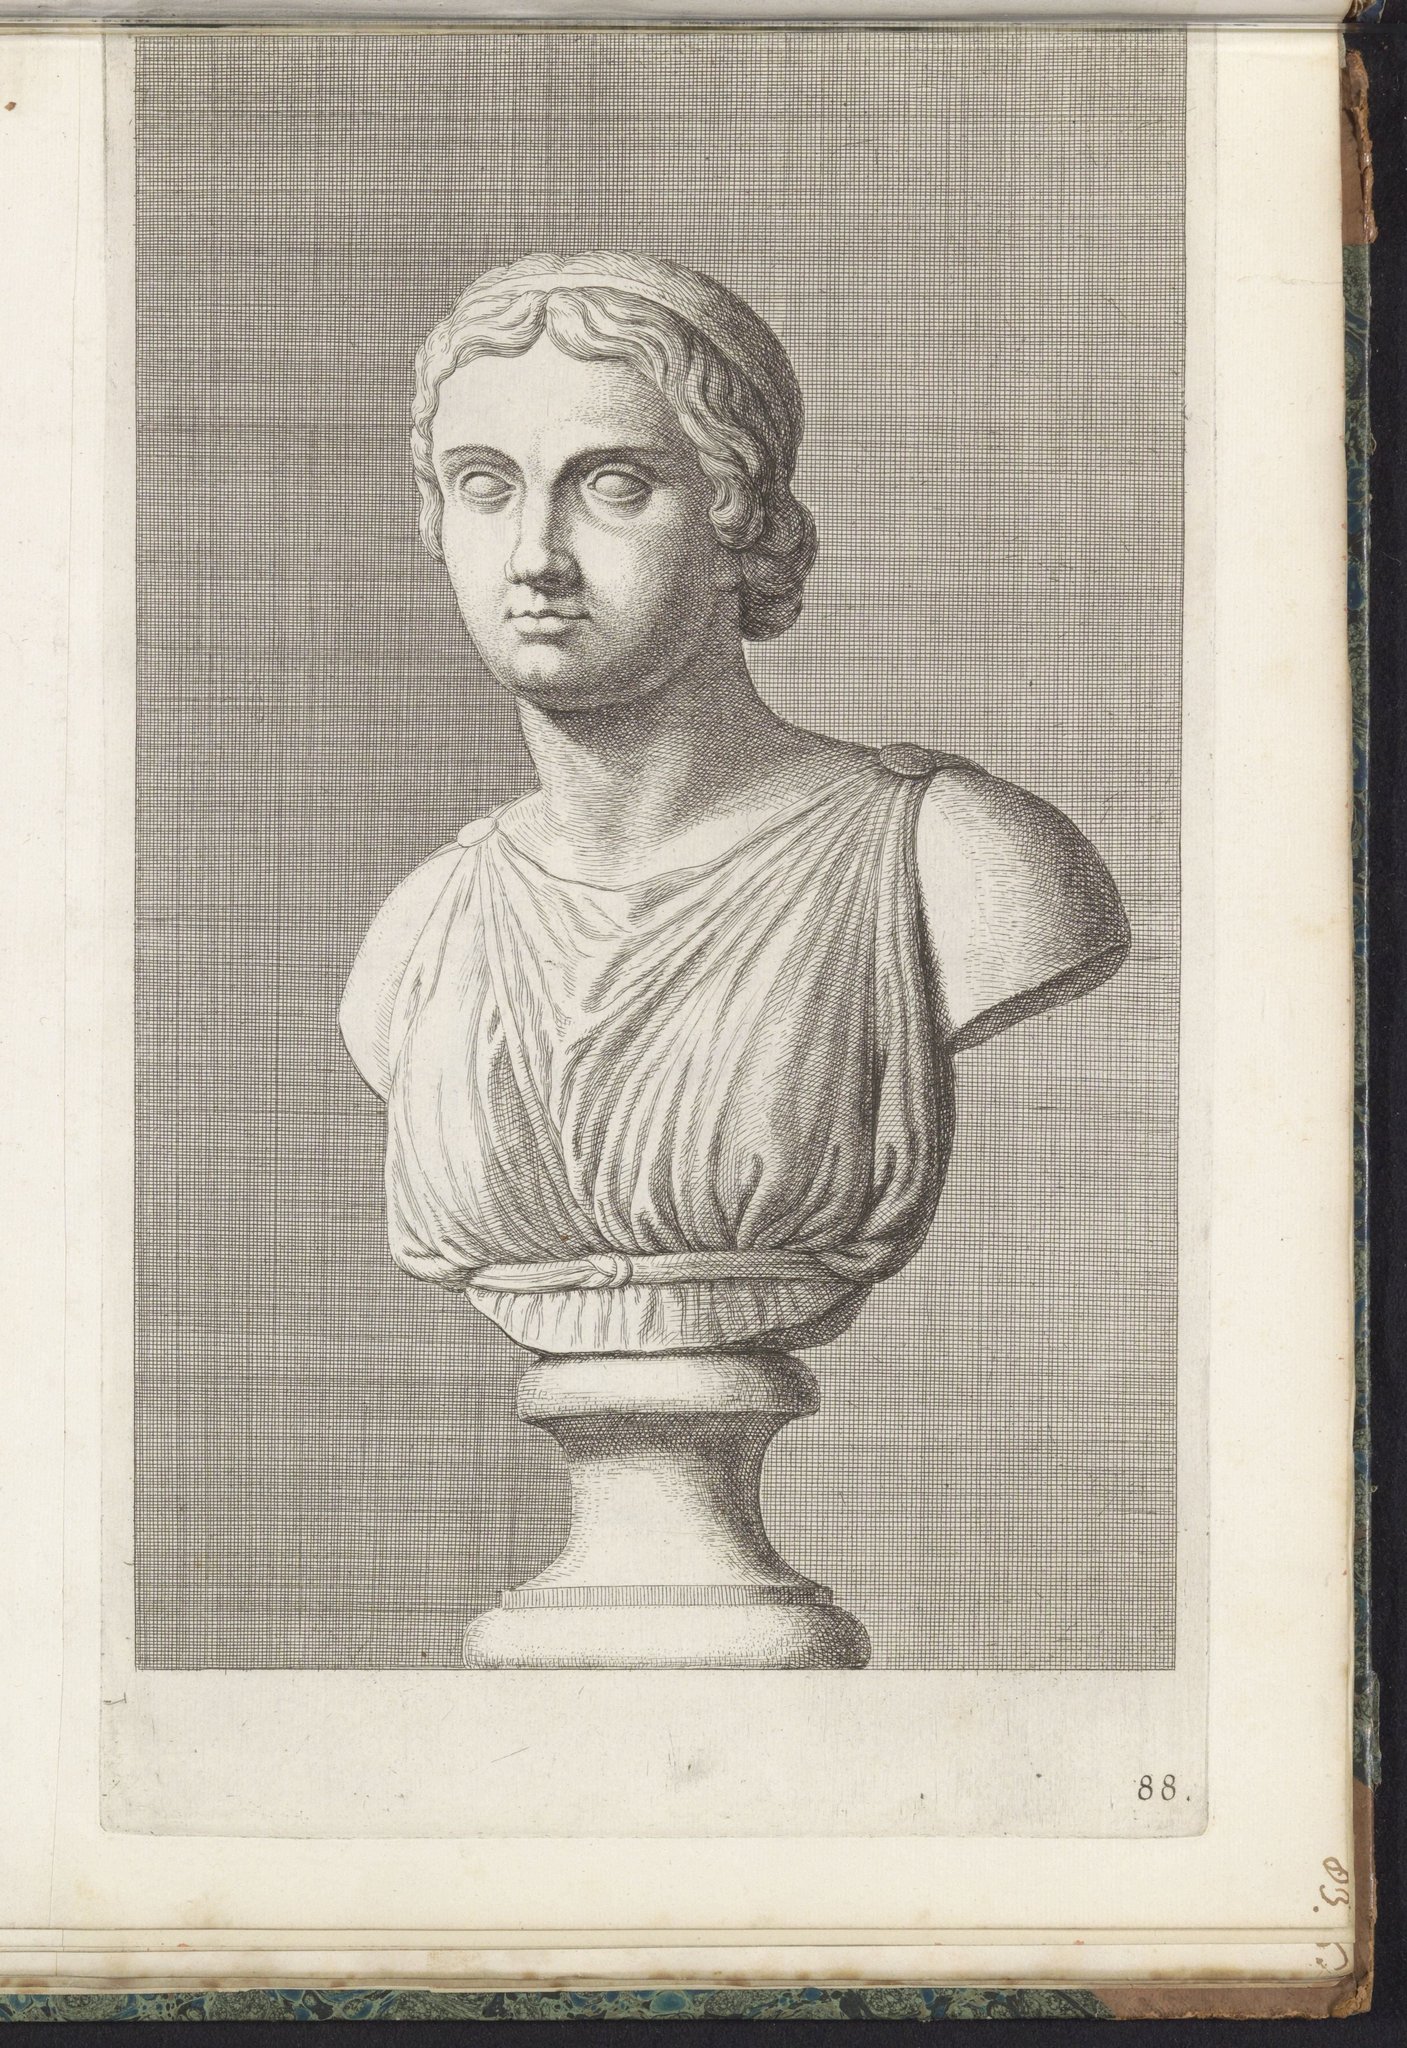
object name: print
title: Buste van een vrouw in toga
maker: hubert quellinus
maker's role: print maker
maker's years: 1619-1687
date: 1646-1670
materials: paper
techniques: engraving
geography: antwerp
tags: piece of sculpture, reproduction of a piece of sculpture, female persons from classical history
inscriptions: number: ‘88’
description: De prent maakt deel uit van een album met een serie prenten naar de sculpturen in de verzameling van Gerard Reynst.